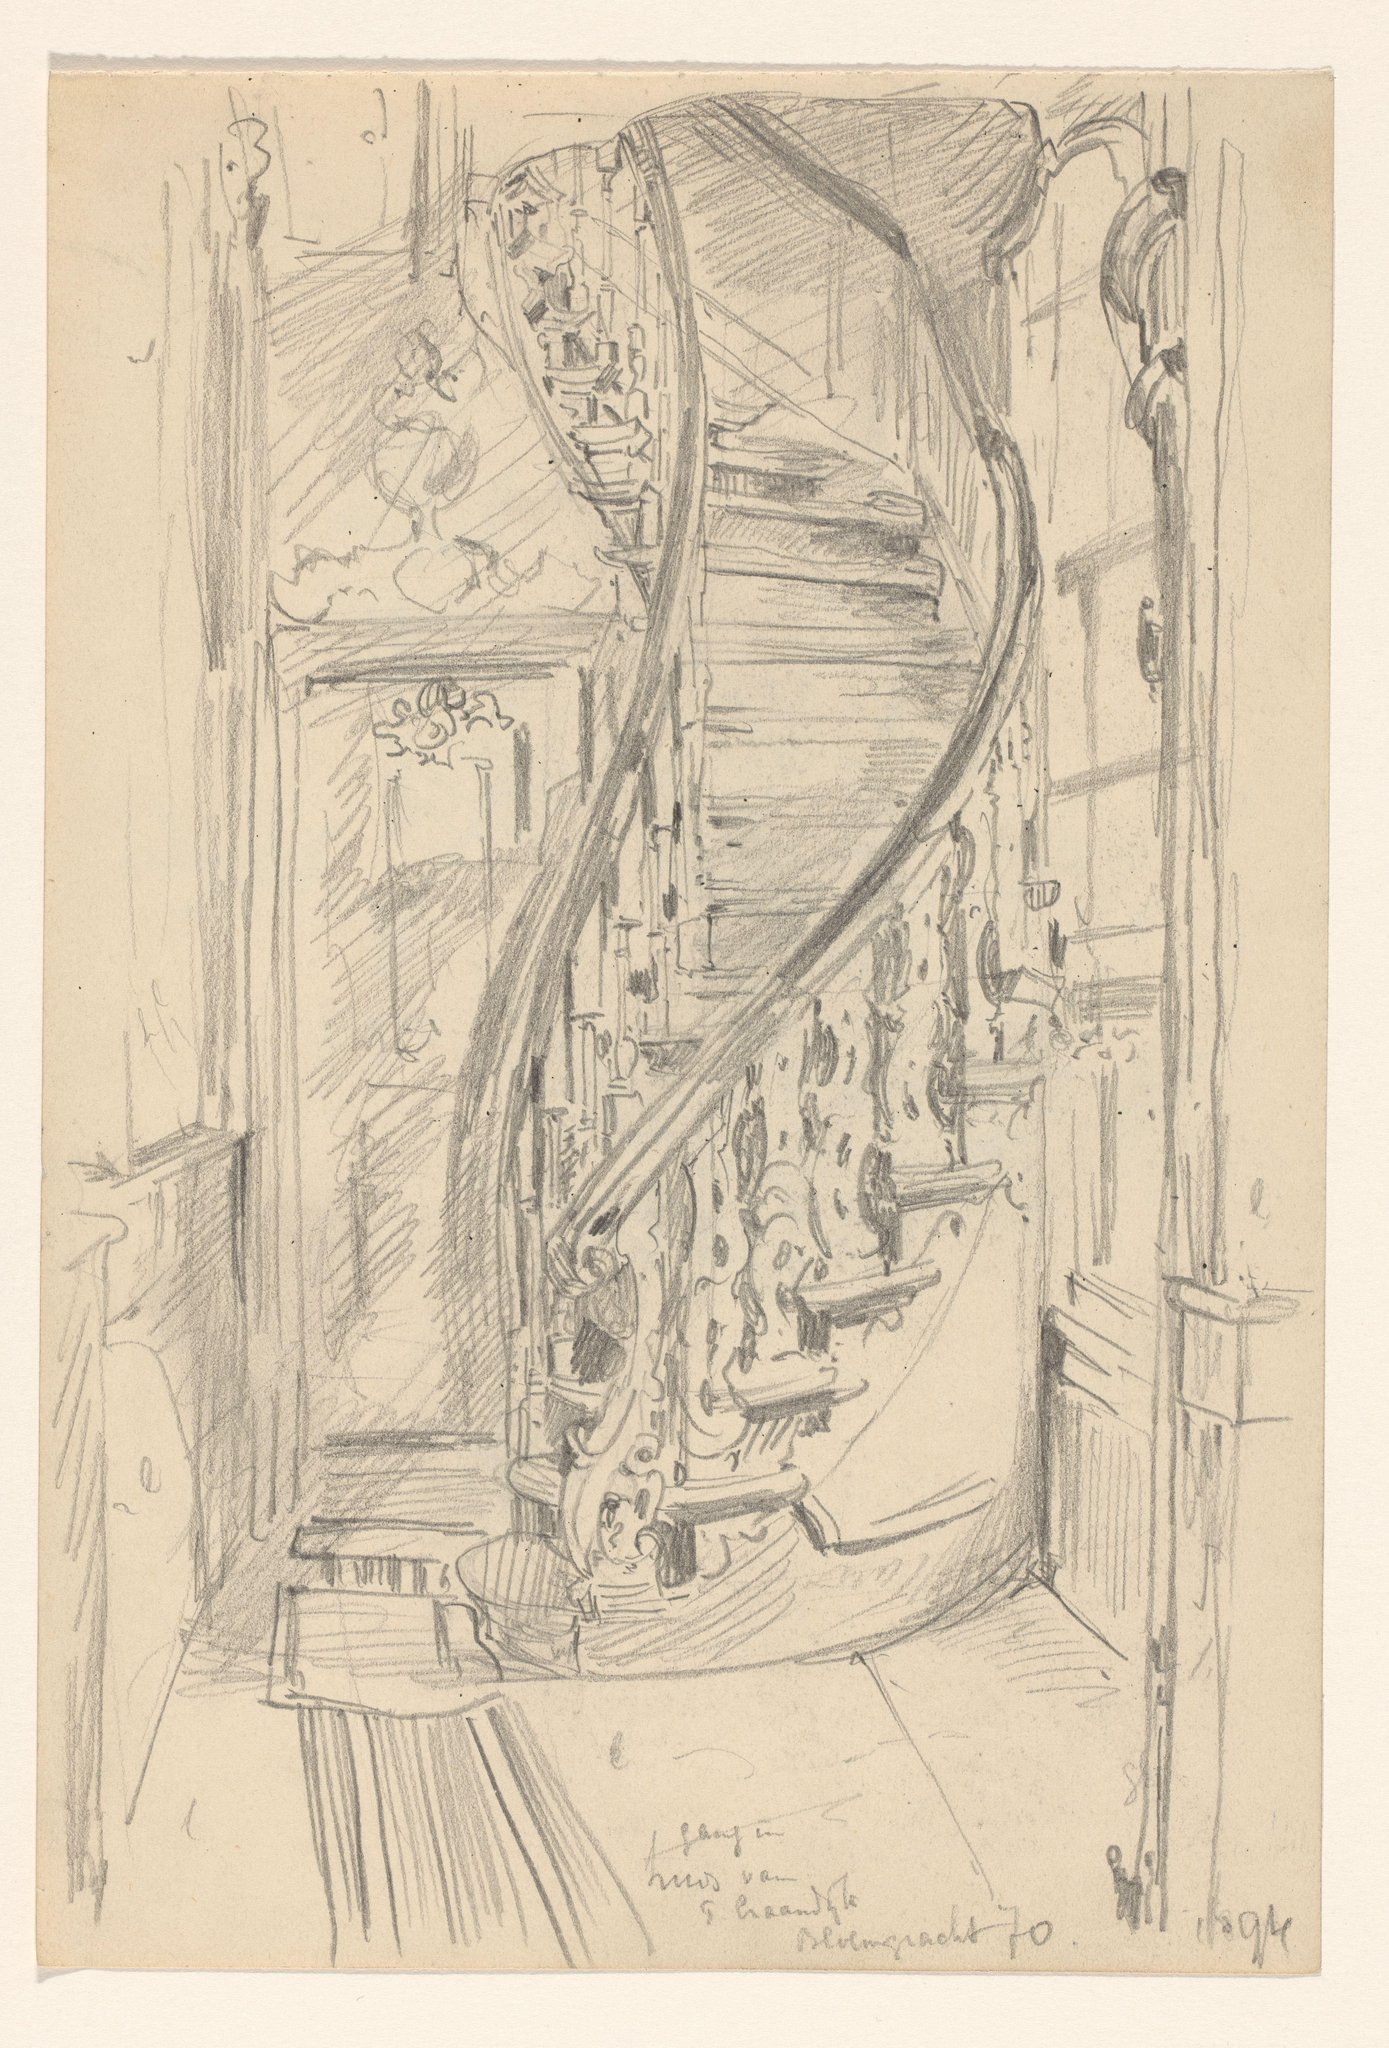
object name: drawing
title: Trap in de gang van Bloemgracht 70 te Amsterdam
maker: jan hoynck van papendrecht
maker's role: draughtsman, painter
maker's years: 1858-1933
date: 1894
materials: paper, pencil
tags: vestibule, hall, staircase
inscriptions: annotation: ‘gang in/ huis van/ G. Craandijk/ Bloemgracht 70. 1894’